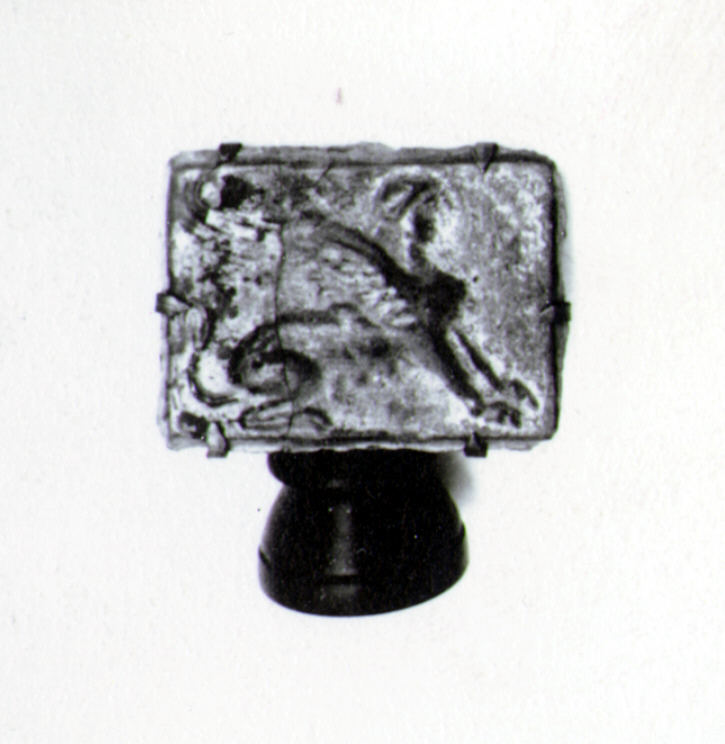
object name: plaque of sphinx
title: Glass plaque with sphinx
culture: roman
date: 1-100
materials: glass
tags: sphinx